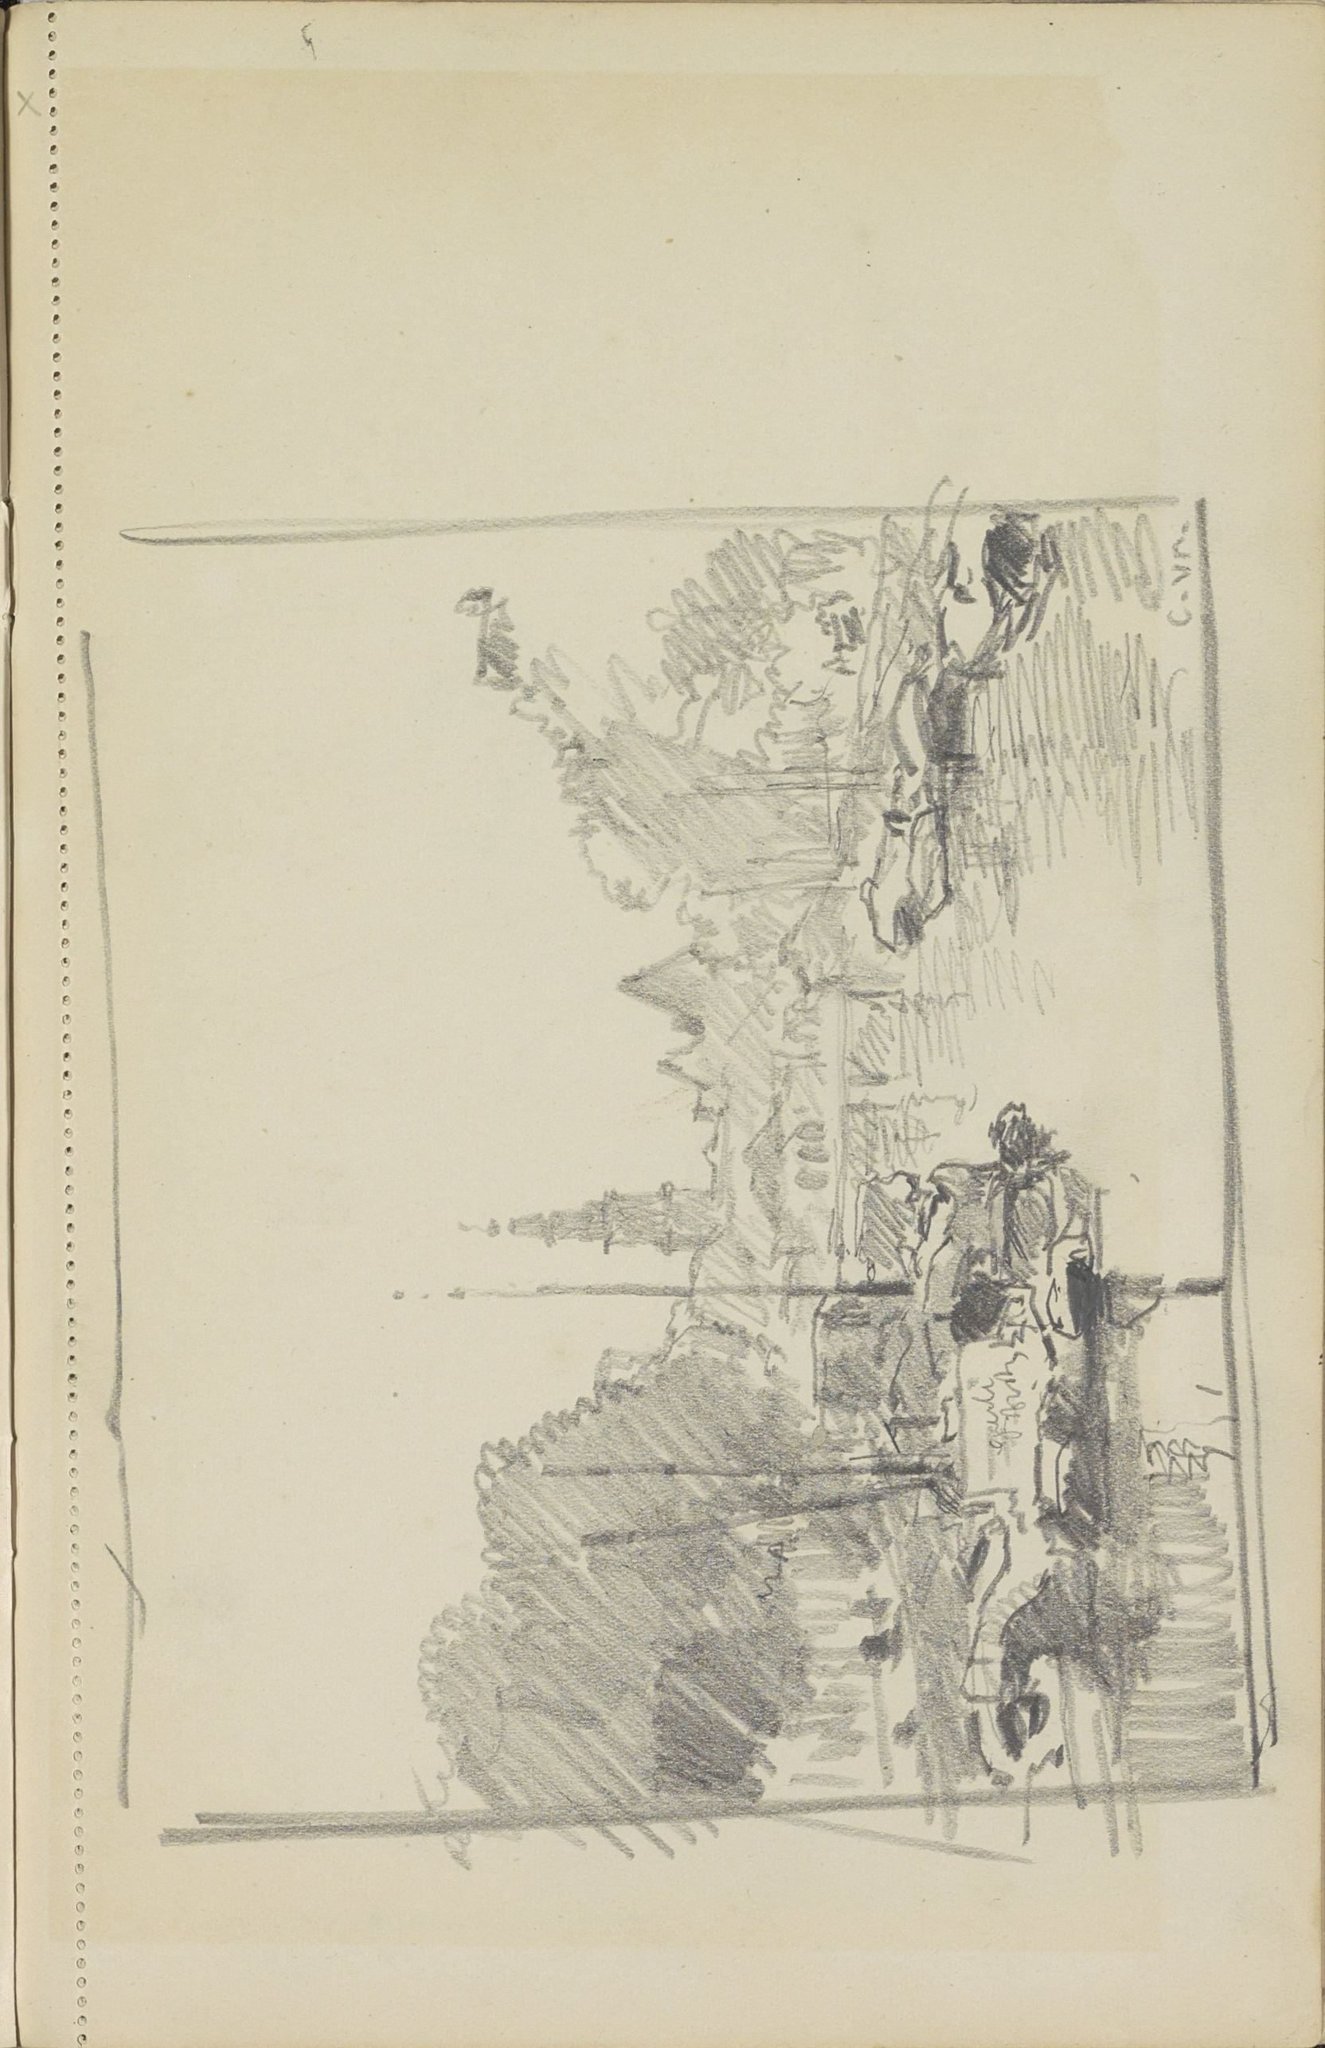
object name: sketchbook leaf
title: Boten op een gracht te Amsterdam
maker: cornelis vreedenburgh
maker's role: draughtsman, print maker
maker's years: 1880-1946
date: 1890-1946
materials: paper, pencil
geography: amsterdam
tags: canals, waters (in city), amsterdam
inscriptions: signature: ‘c. vr.’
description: Op de achtergrond een toren. Blad 40 recto uit een schetsboek met 56 bladen.